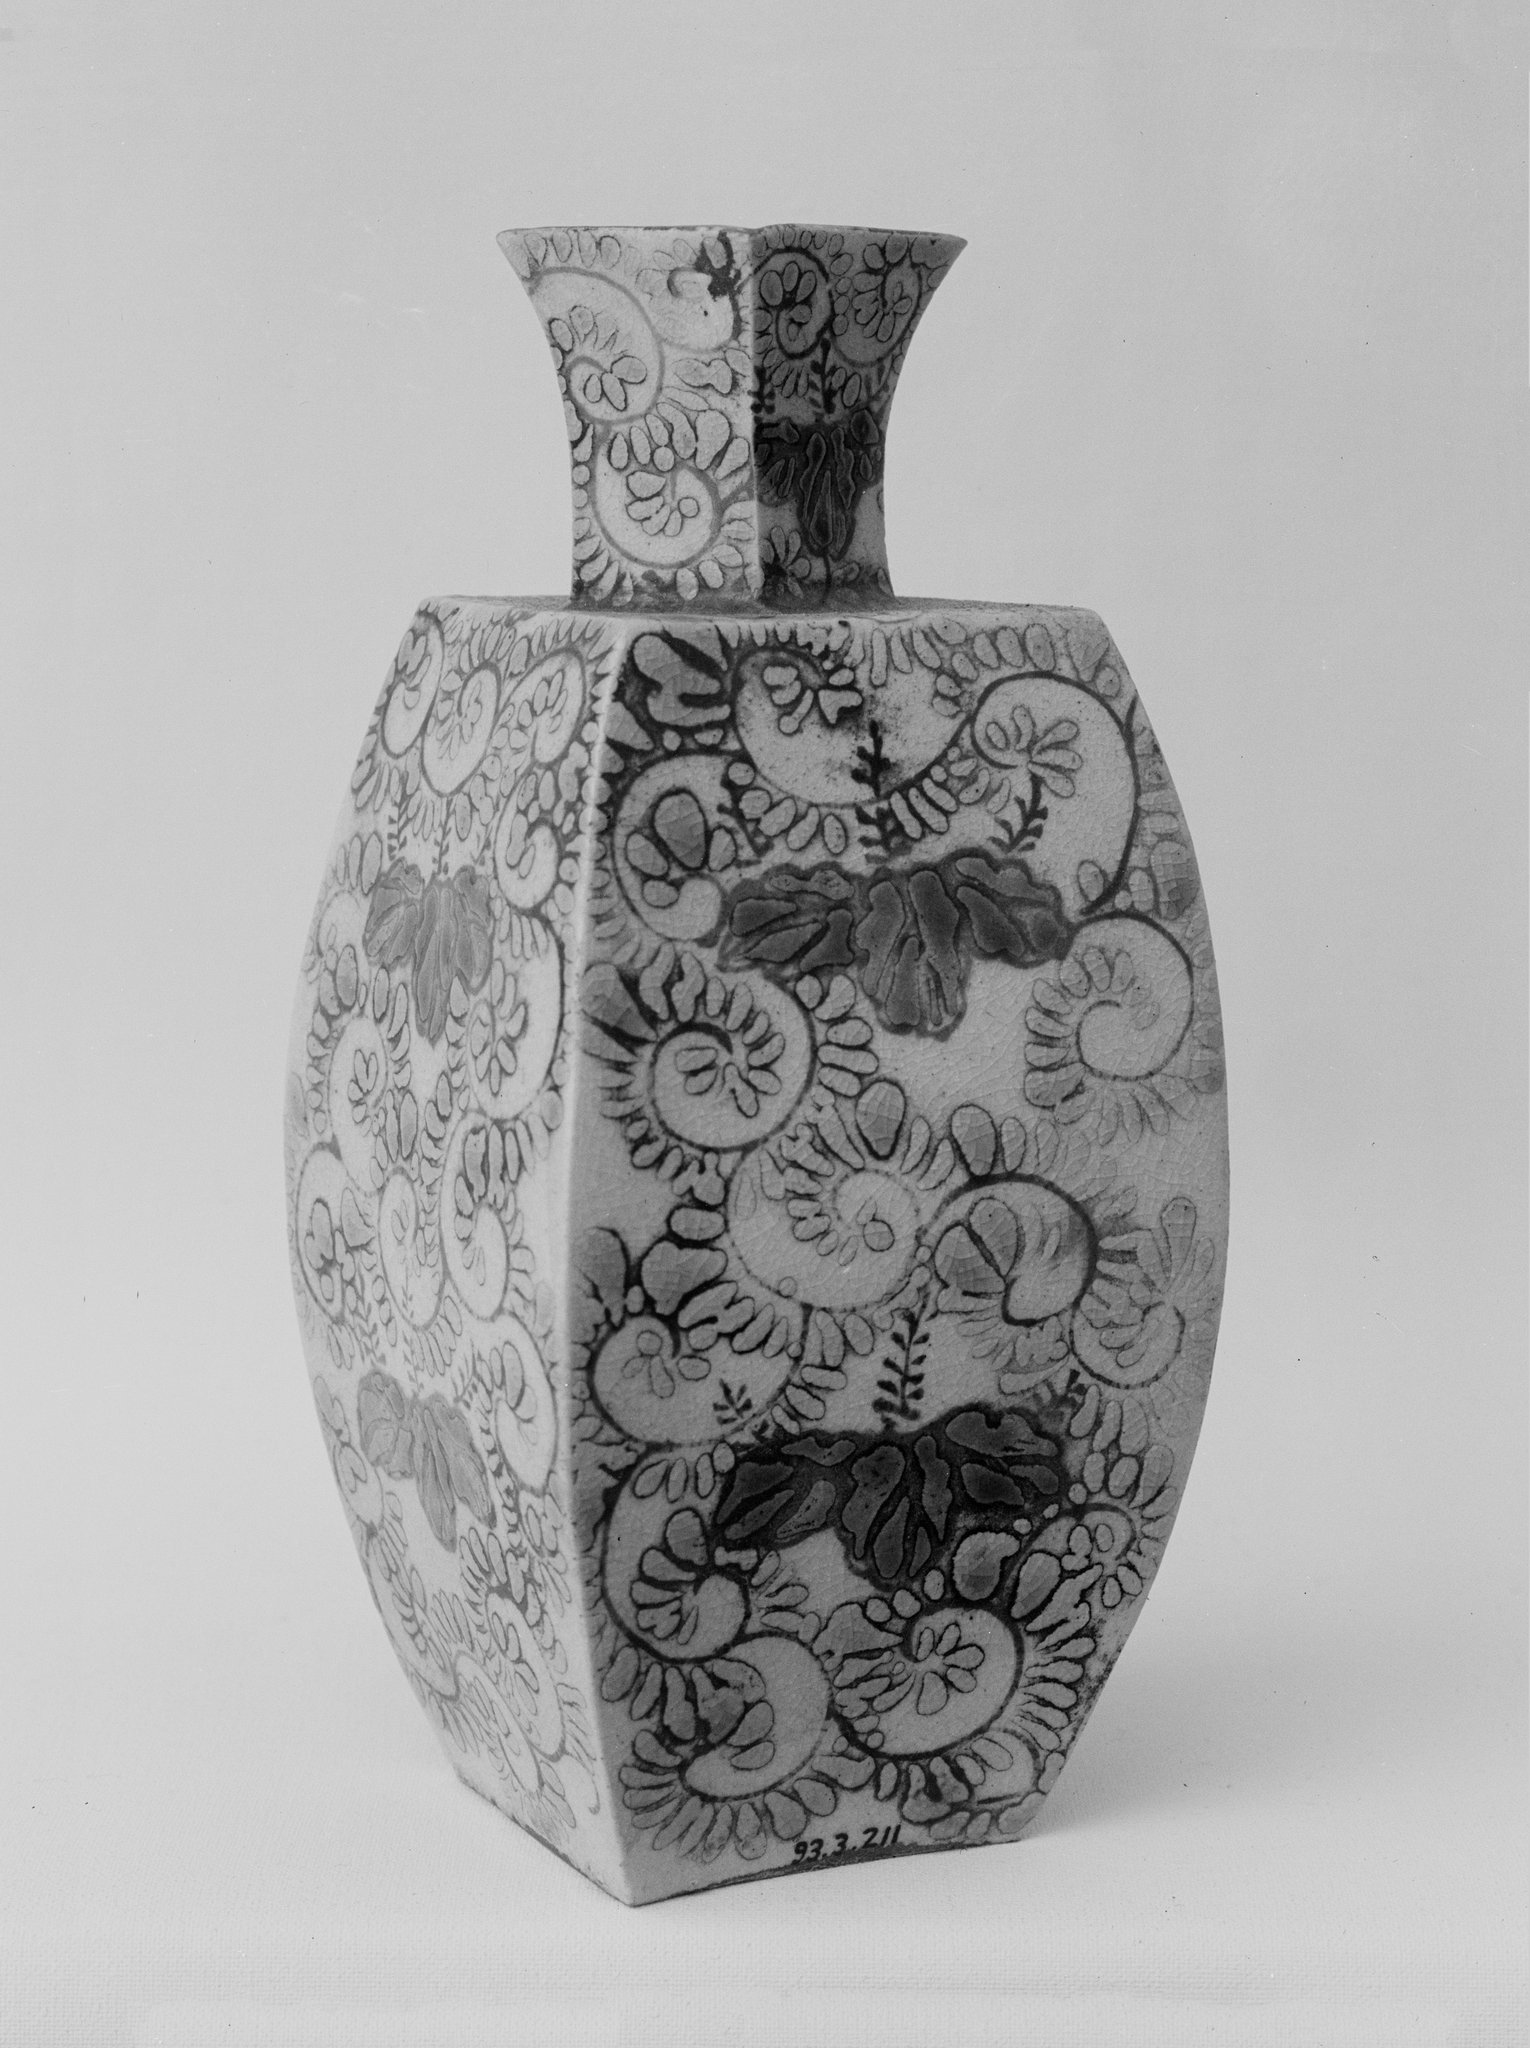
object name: vase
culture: japanese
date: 1730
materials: clay, enamel, glaze, gold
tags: leaves